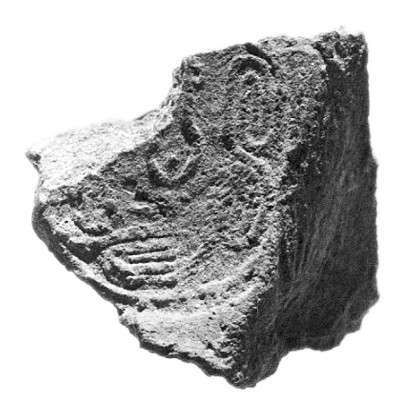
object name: sealing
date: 1981-1640 BCE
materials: mud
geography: egypt